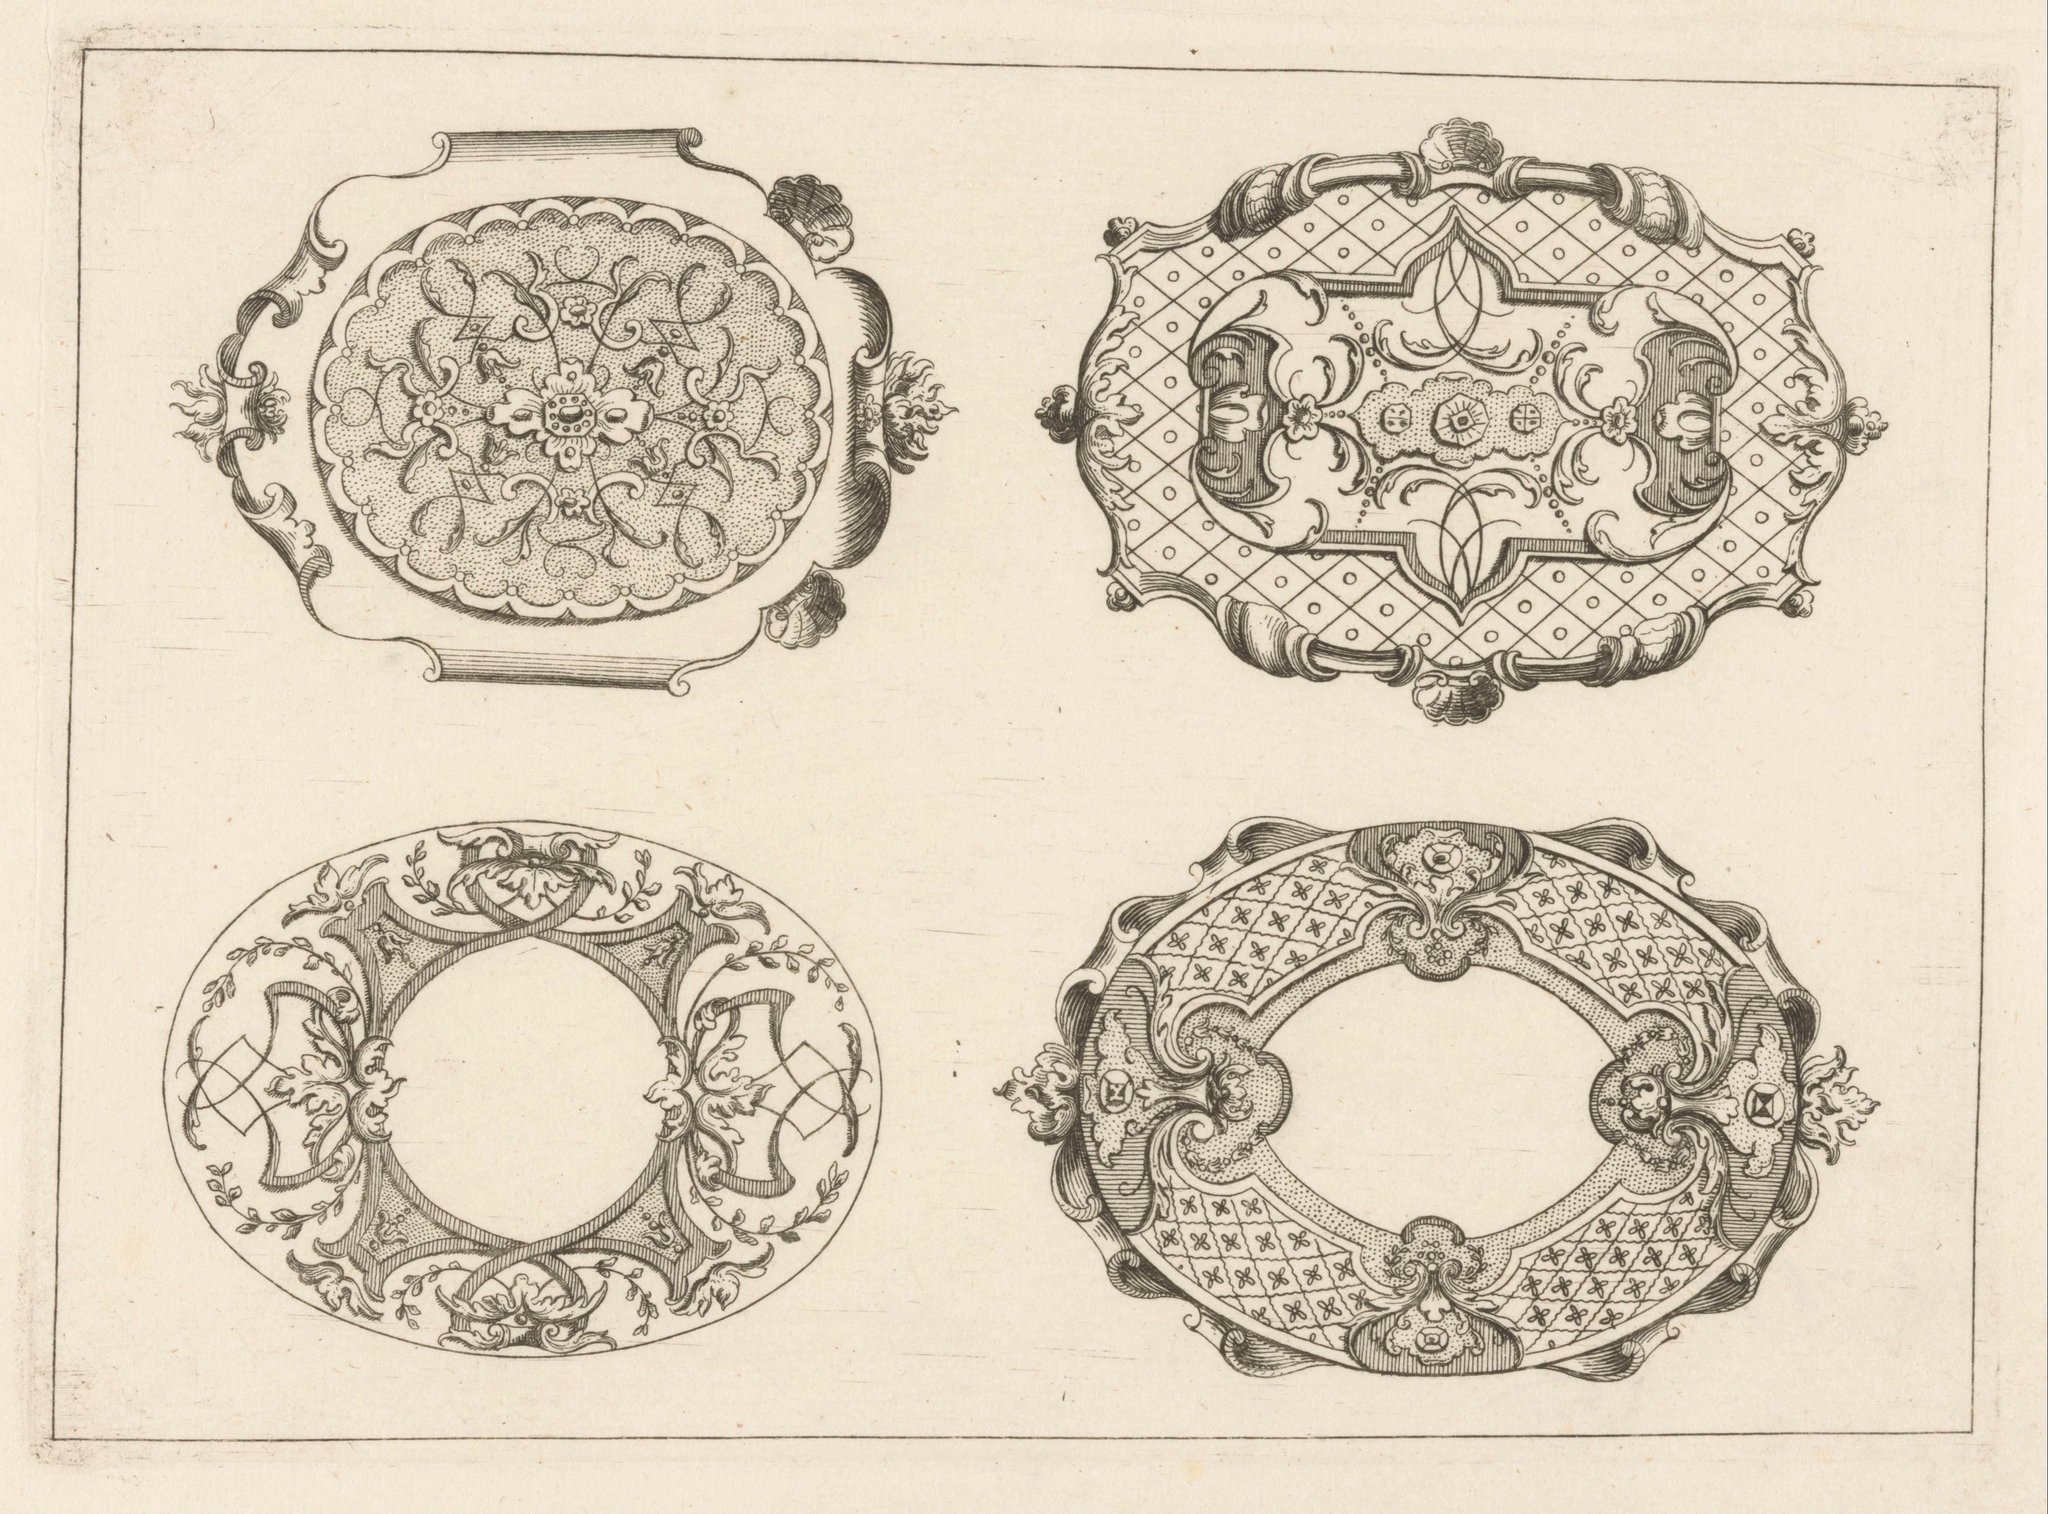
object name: print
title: Neue invention oder entwurff von Schnupftoback Dosen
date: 1670-1725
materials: paper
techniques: etching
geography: germany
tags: ornaments ~ art, snuff-box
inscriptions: collector's mark: Lugt 2228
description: Vier deksels van snuifdozen met ornamenten en bladmotieven.